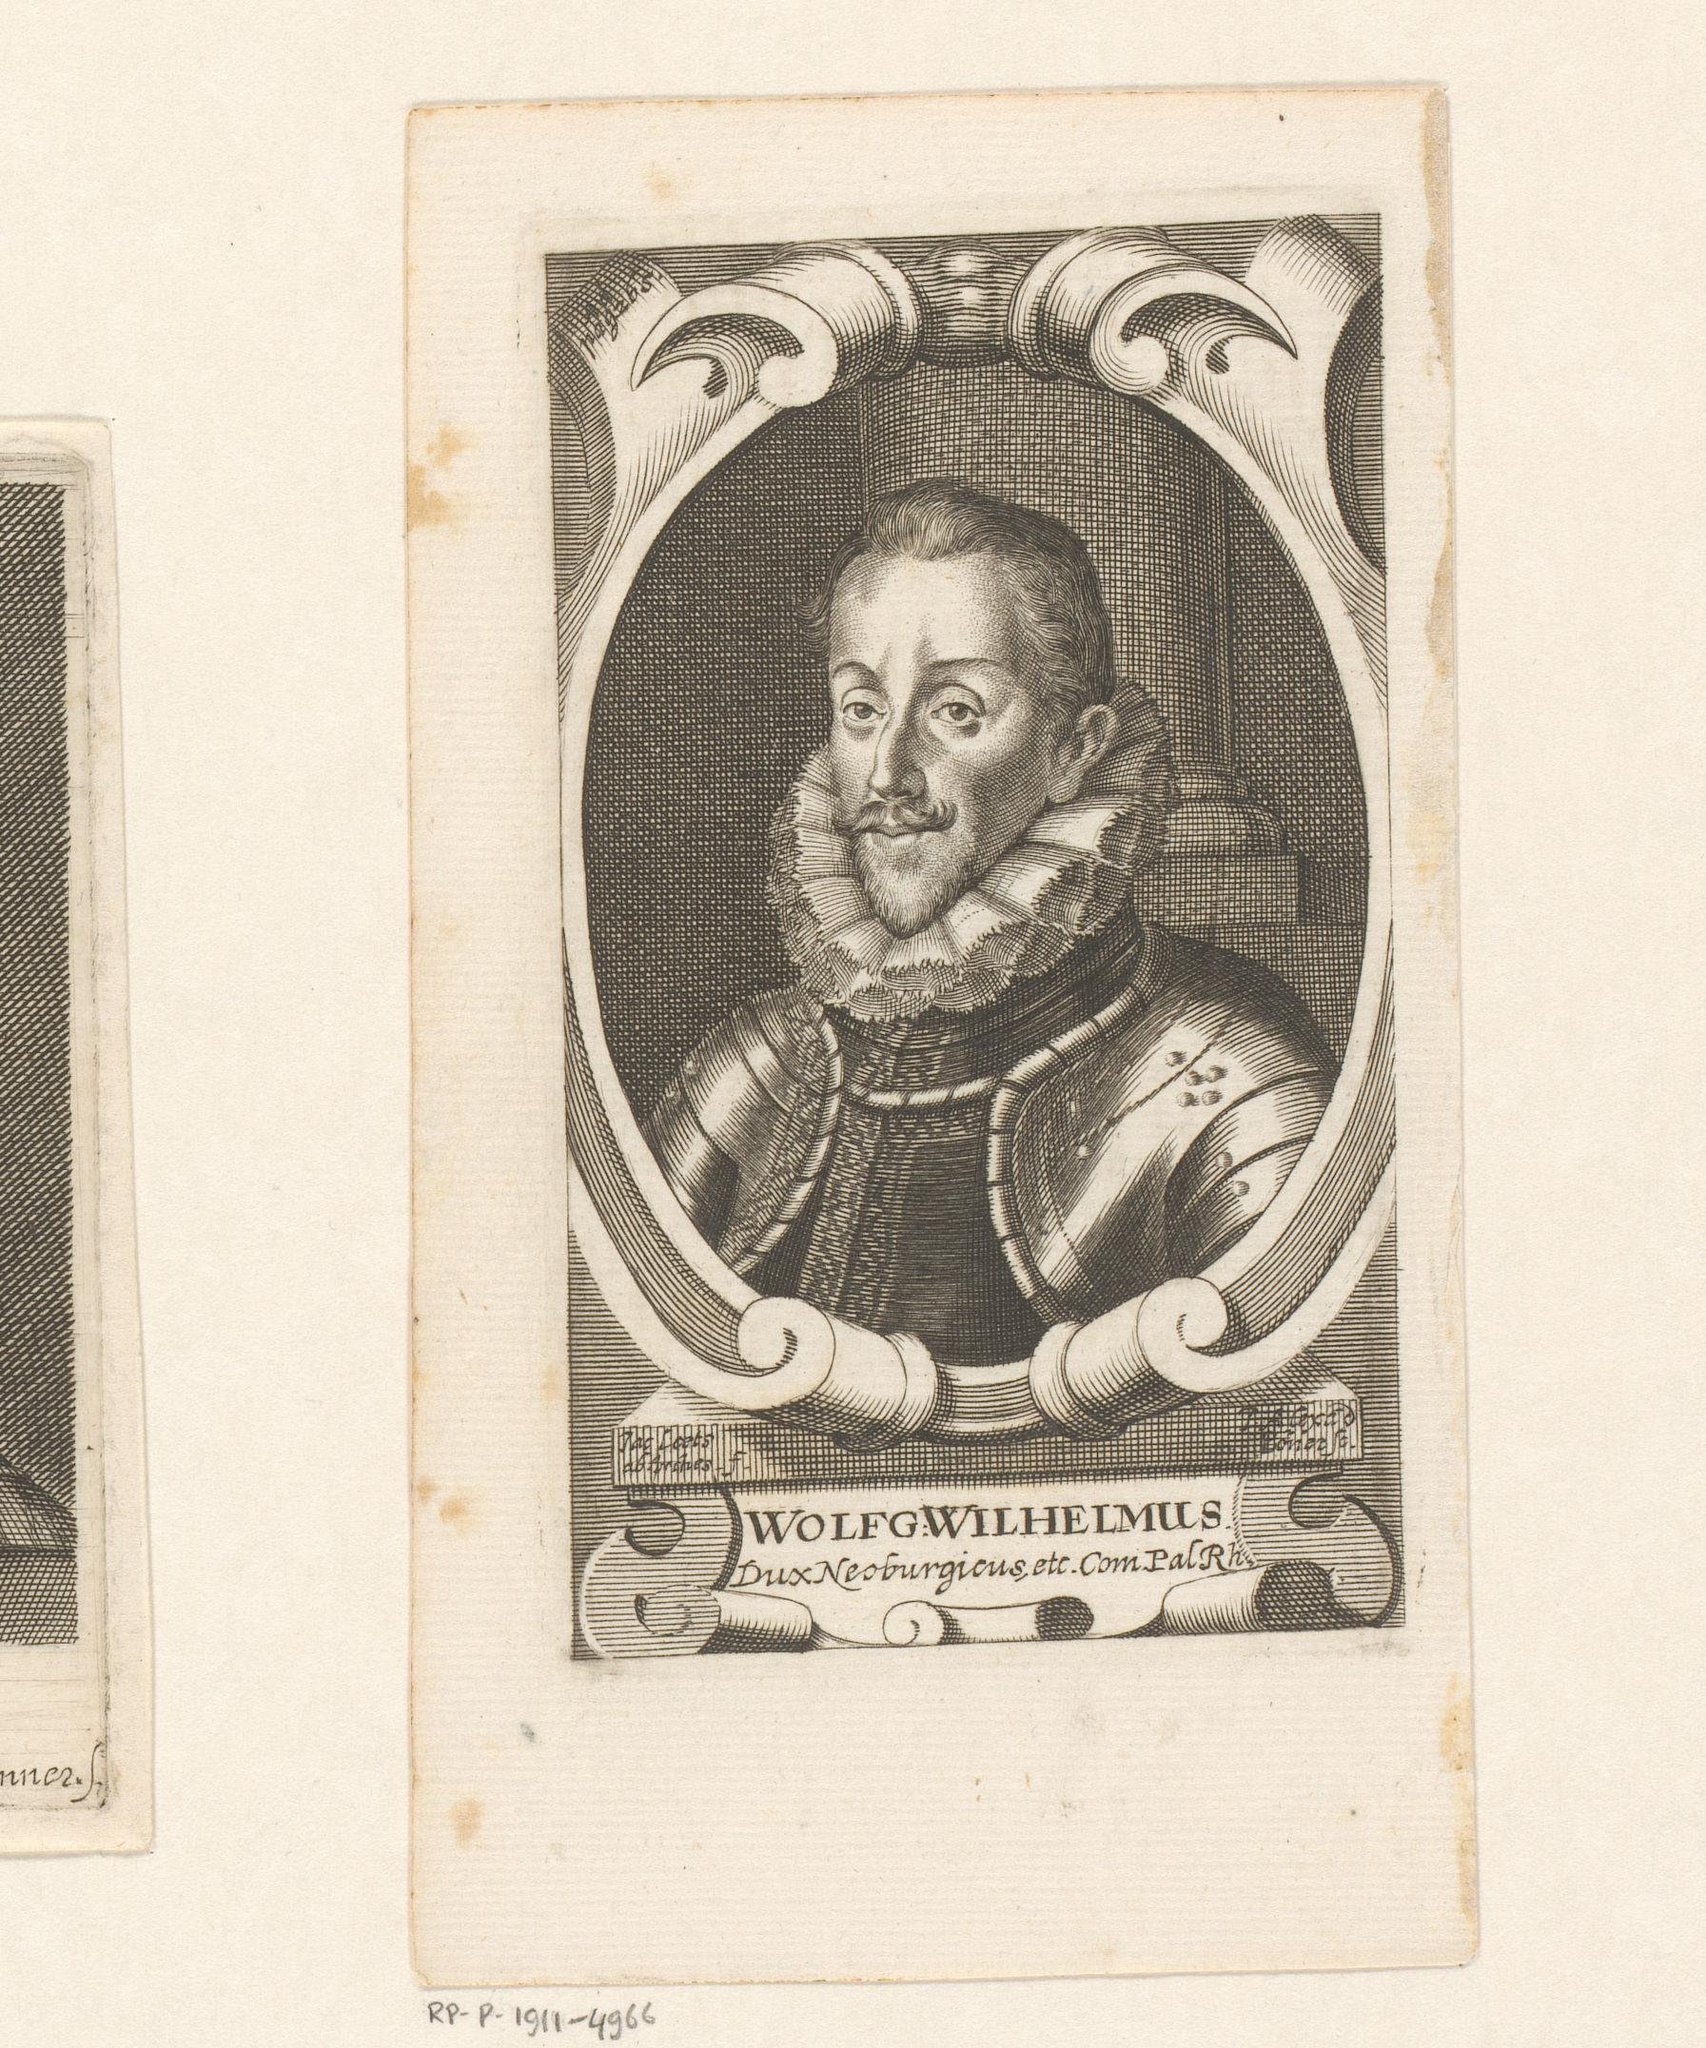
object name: print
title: Portret van Wolfgang Willem van de Palts-Neuburg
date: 1675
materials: paper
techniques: engraving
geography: nuremberg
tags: wolfgang willem van de palts-neuburg, armour, historical persons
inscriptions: collector's mark: Lugt 2228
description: Prent afkomstig uit: Bissel, Johannes. Aetatis nostrae gestorum eminentium medulla historica. Septennium II. Amberg: Johann Burger, 1675.